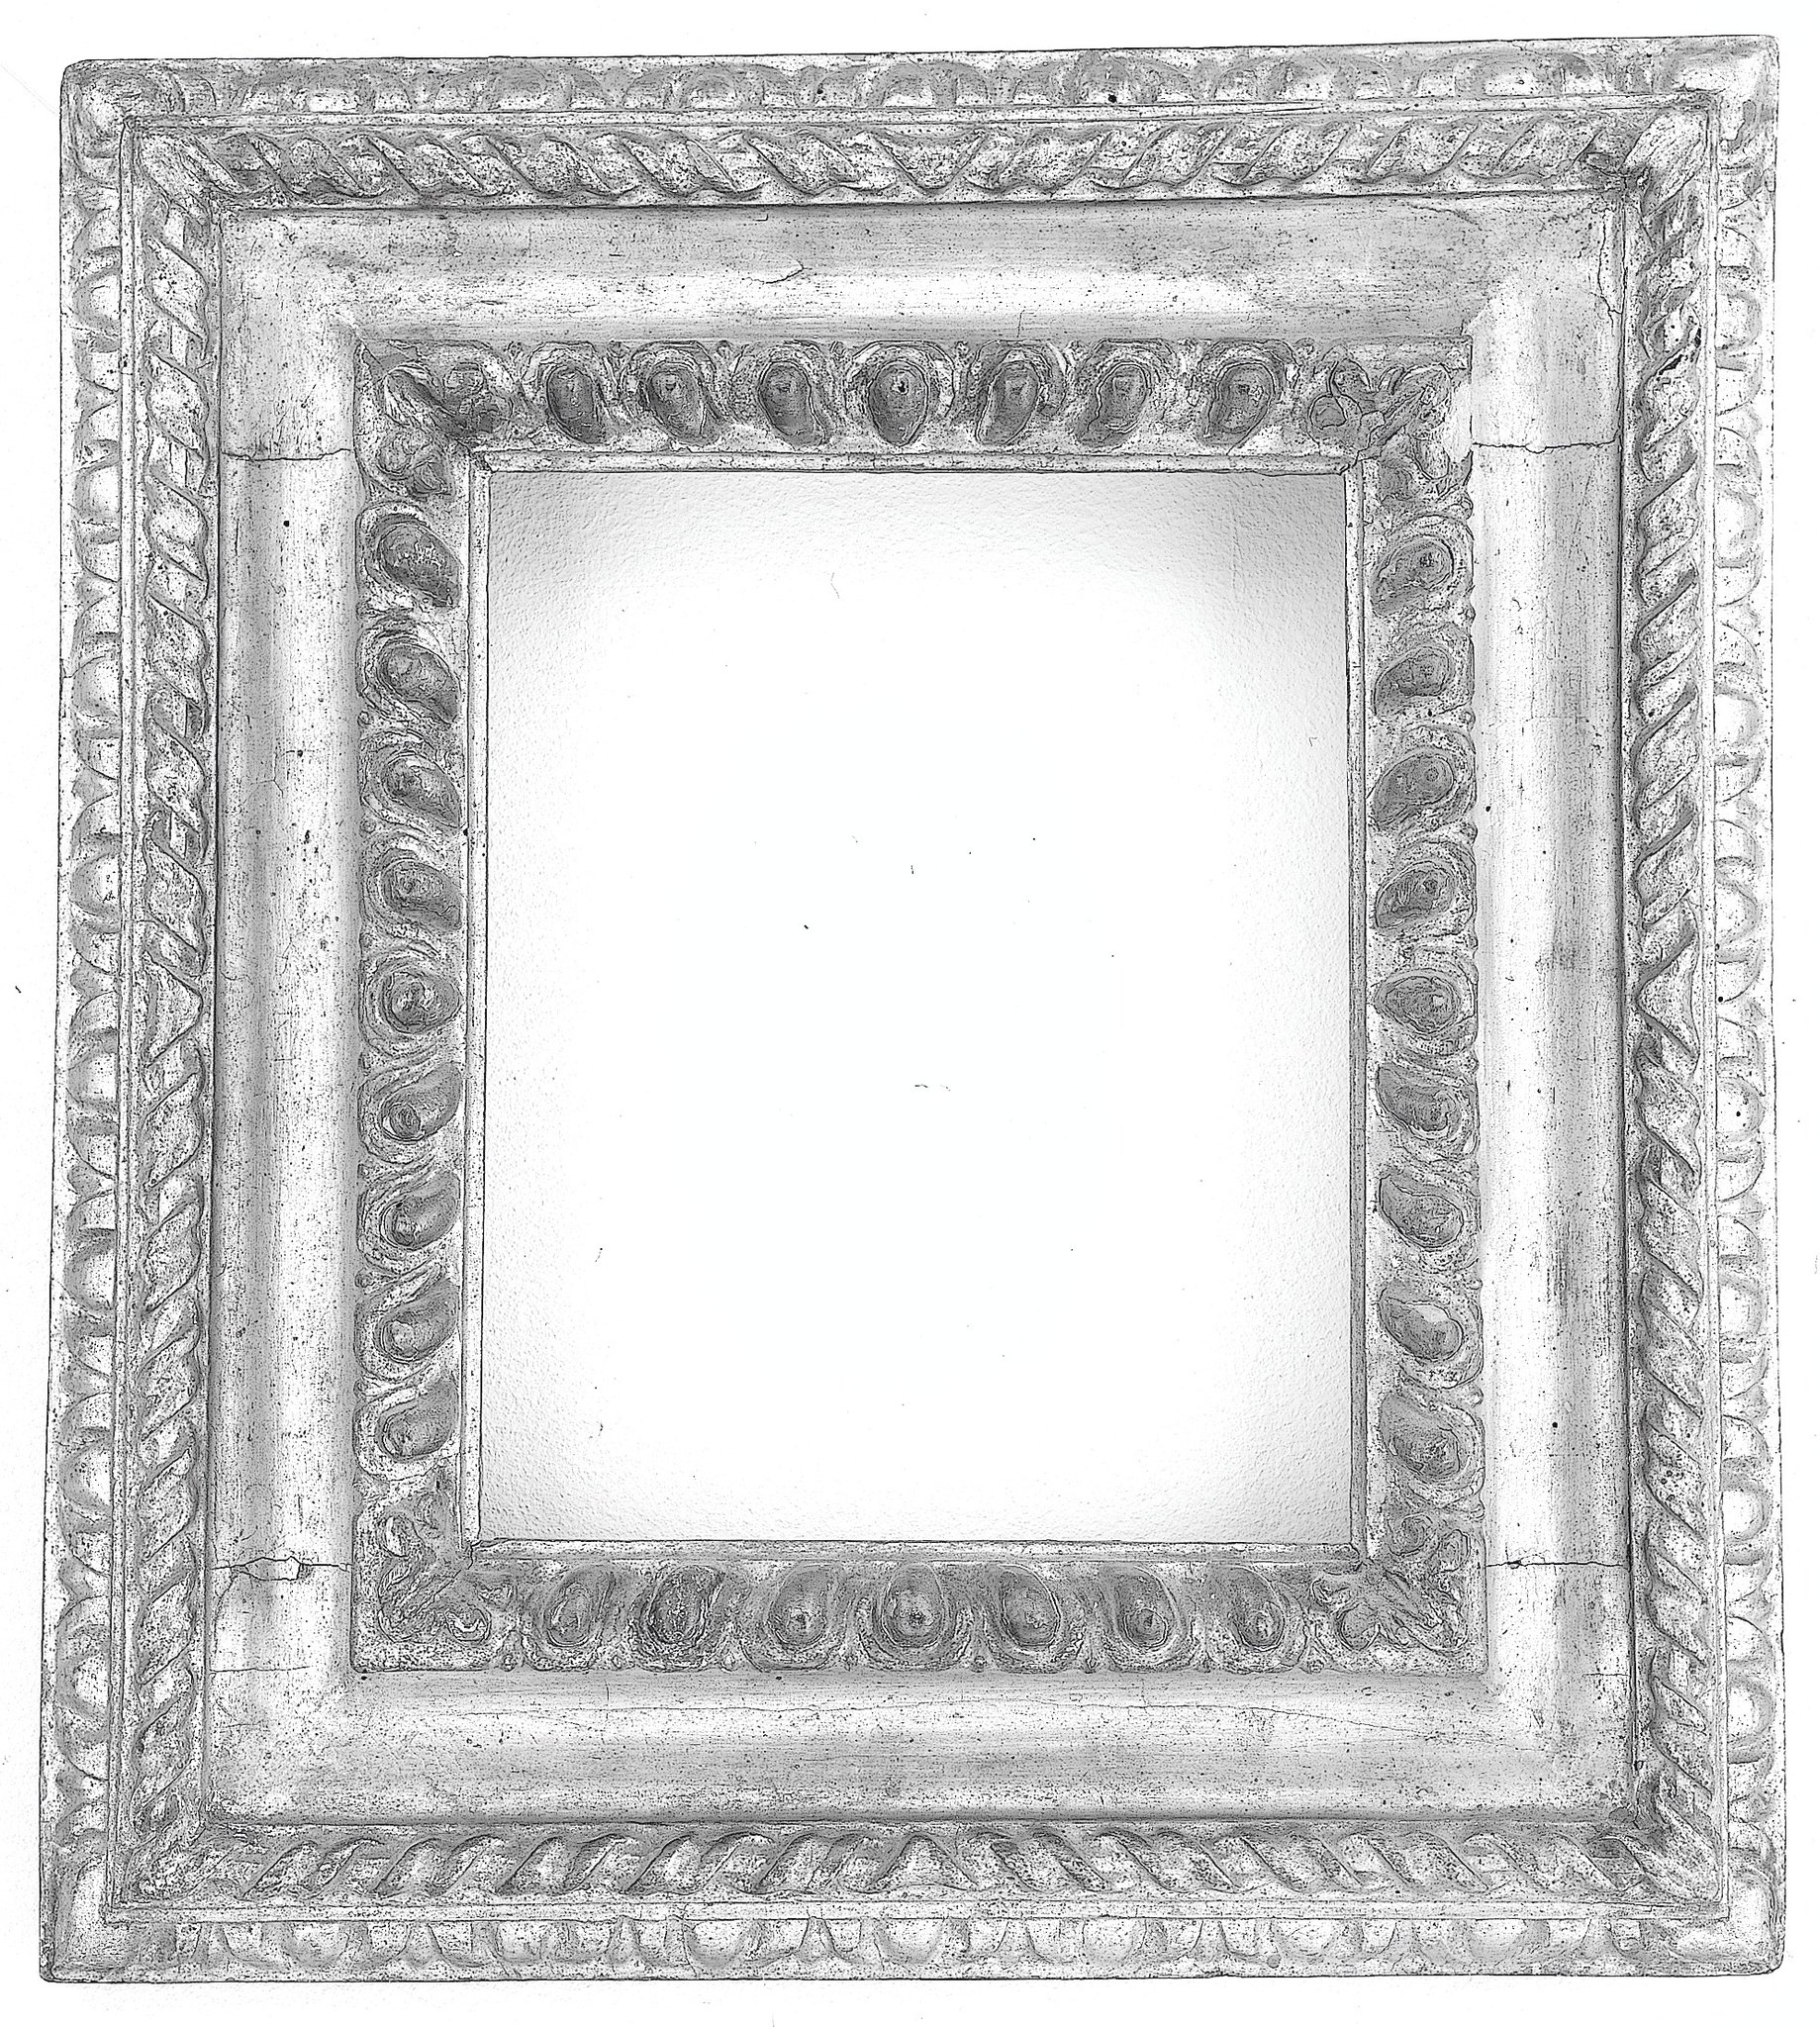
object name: frame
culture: italian, sicilian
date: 1710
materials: wood